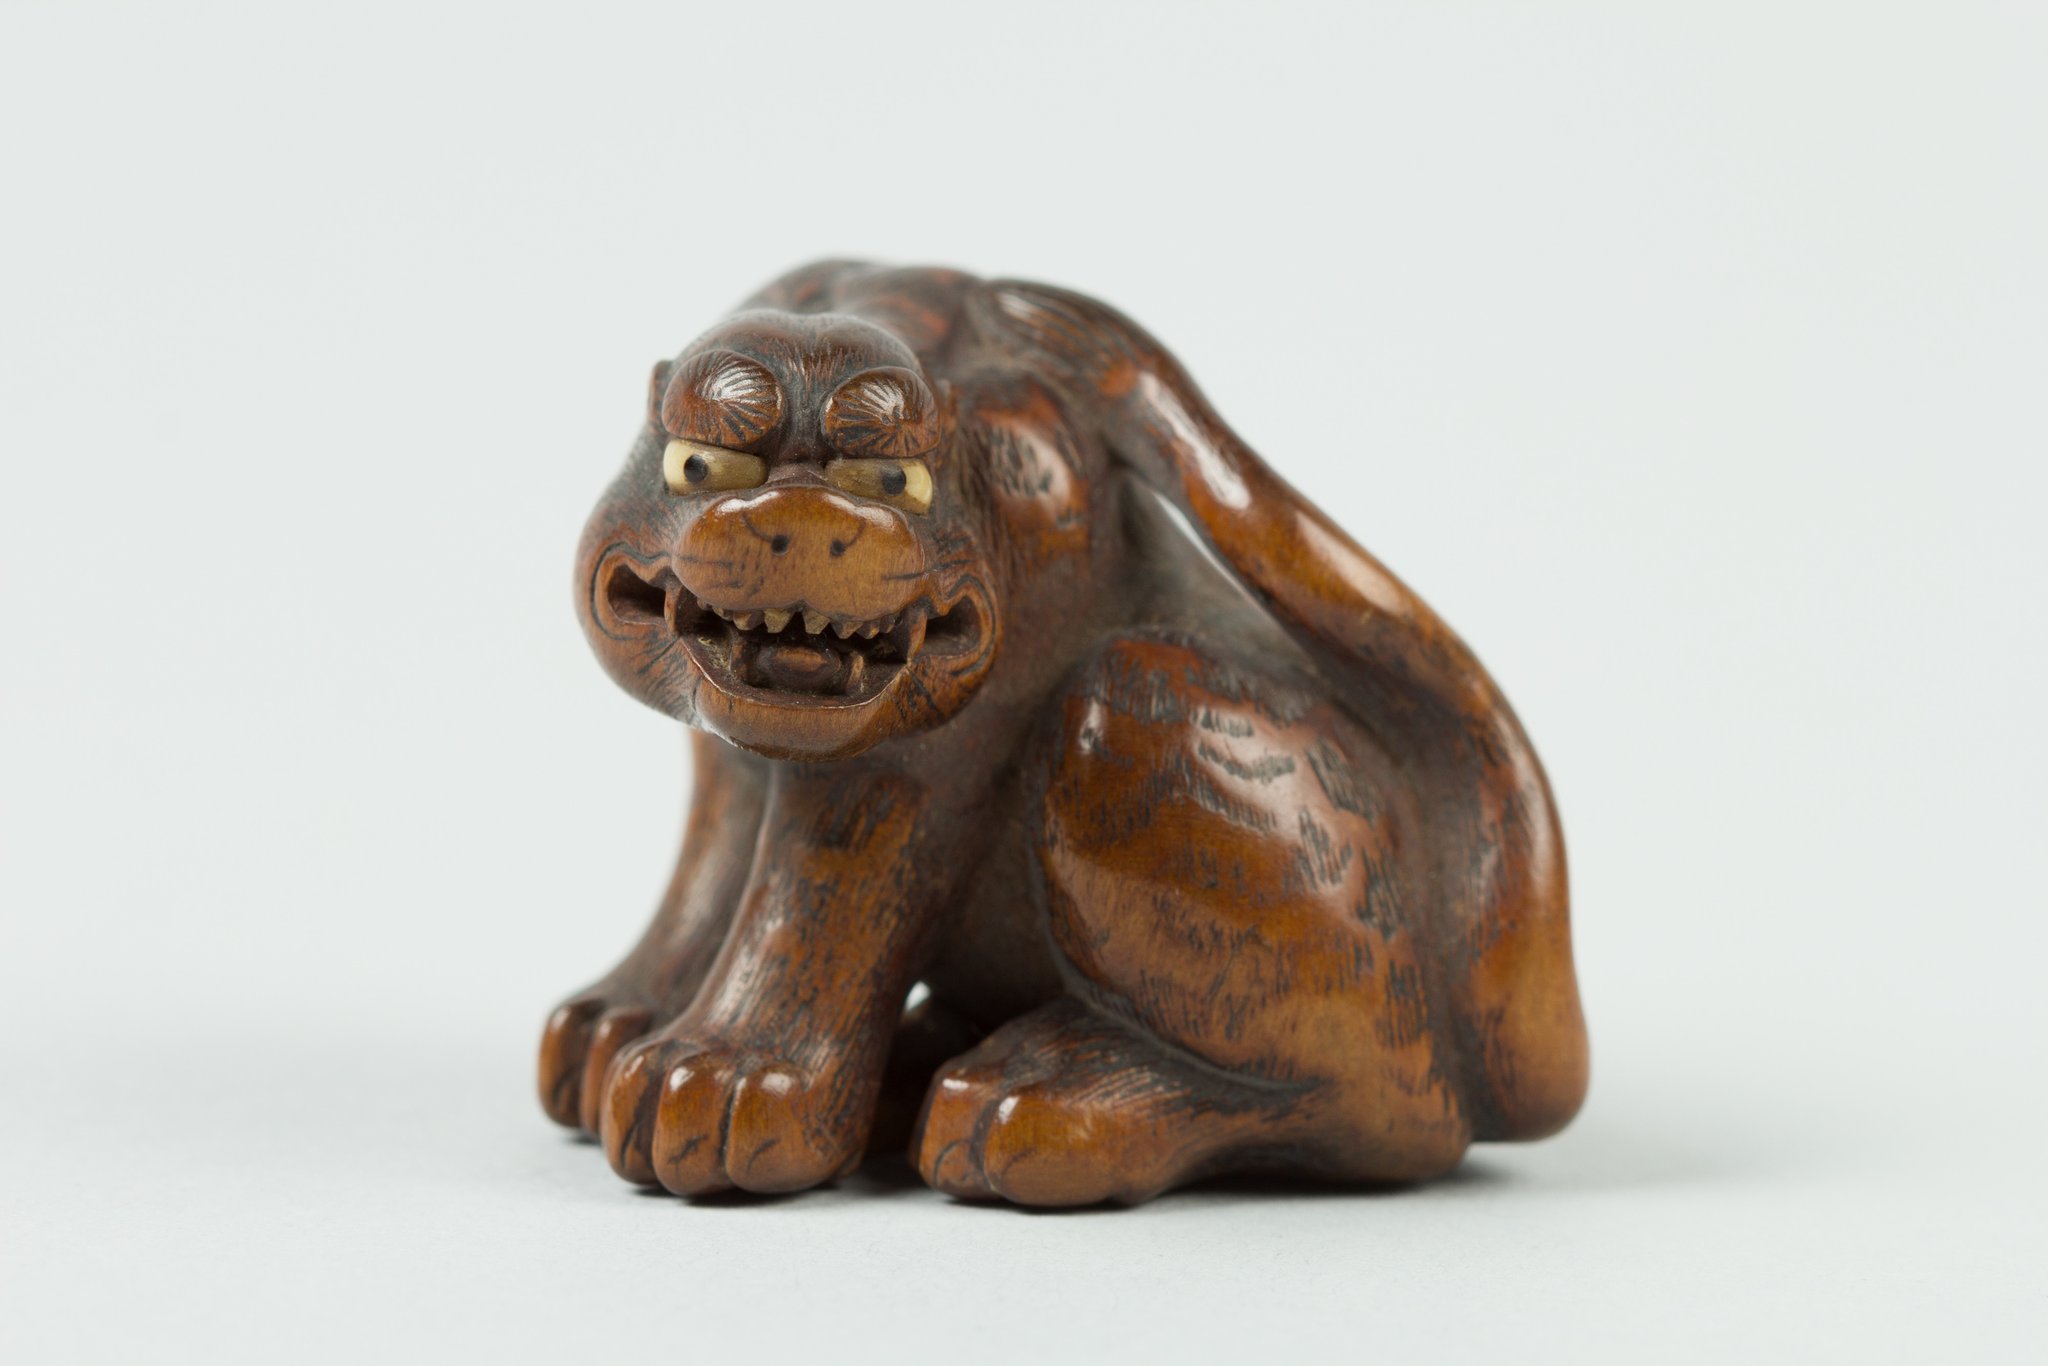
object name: netsuke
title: Netsuke of Tiger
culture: japanese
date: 1801-1900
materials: wood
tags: tigers